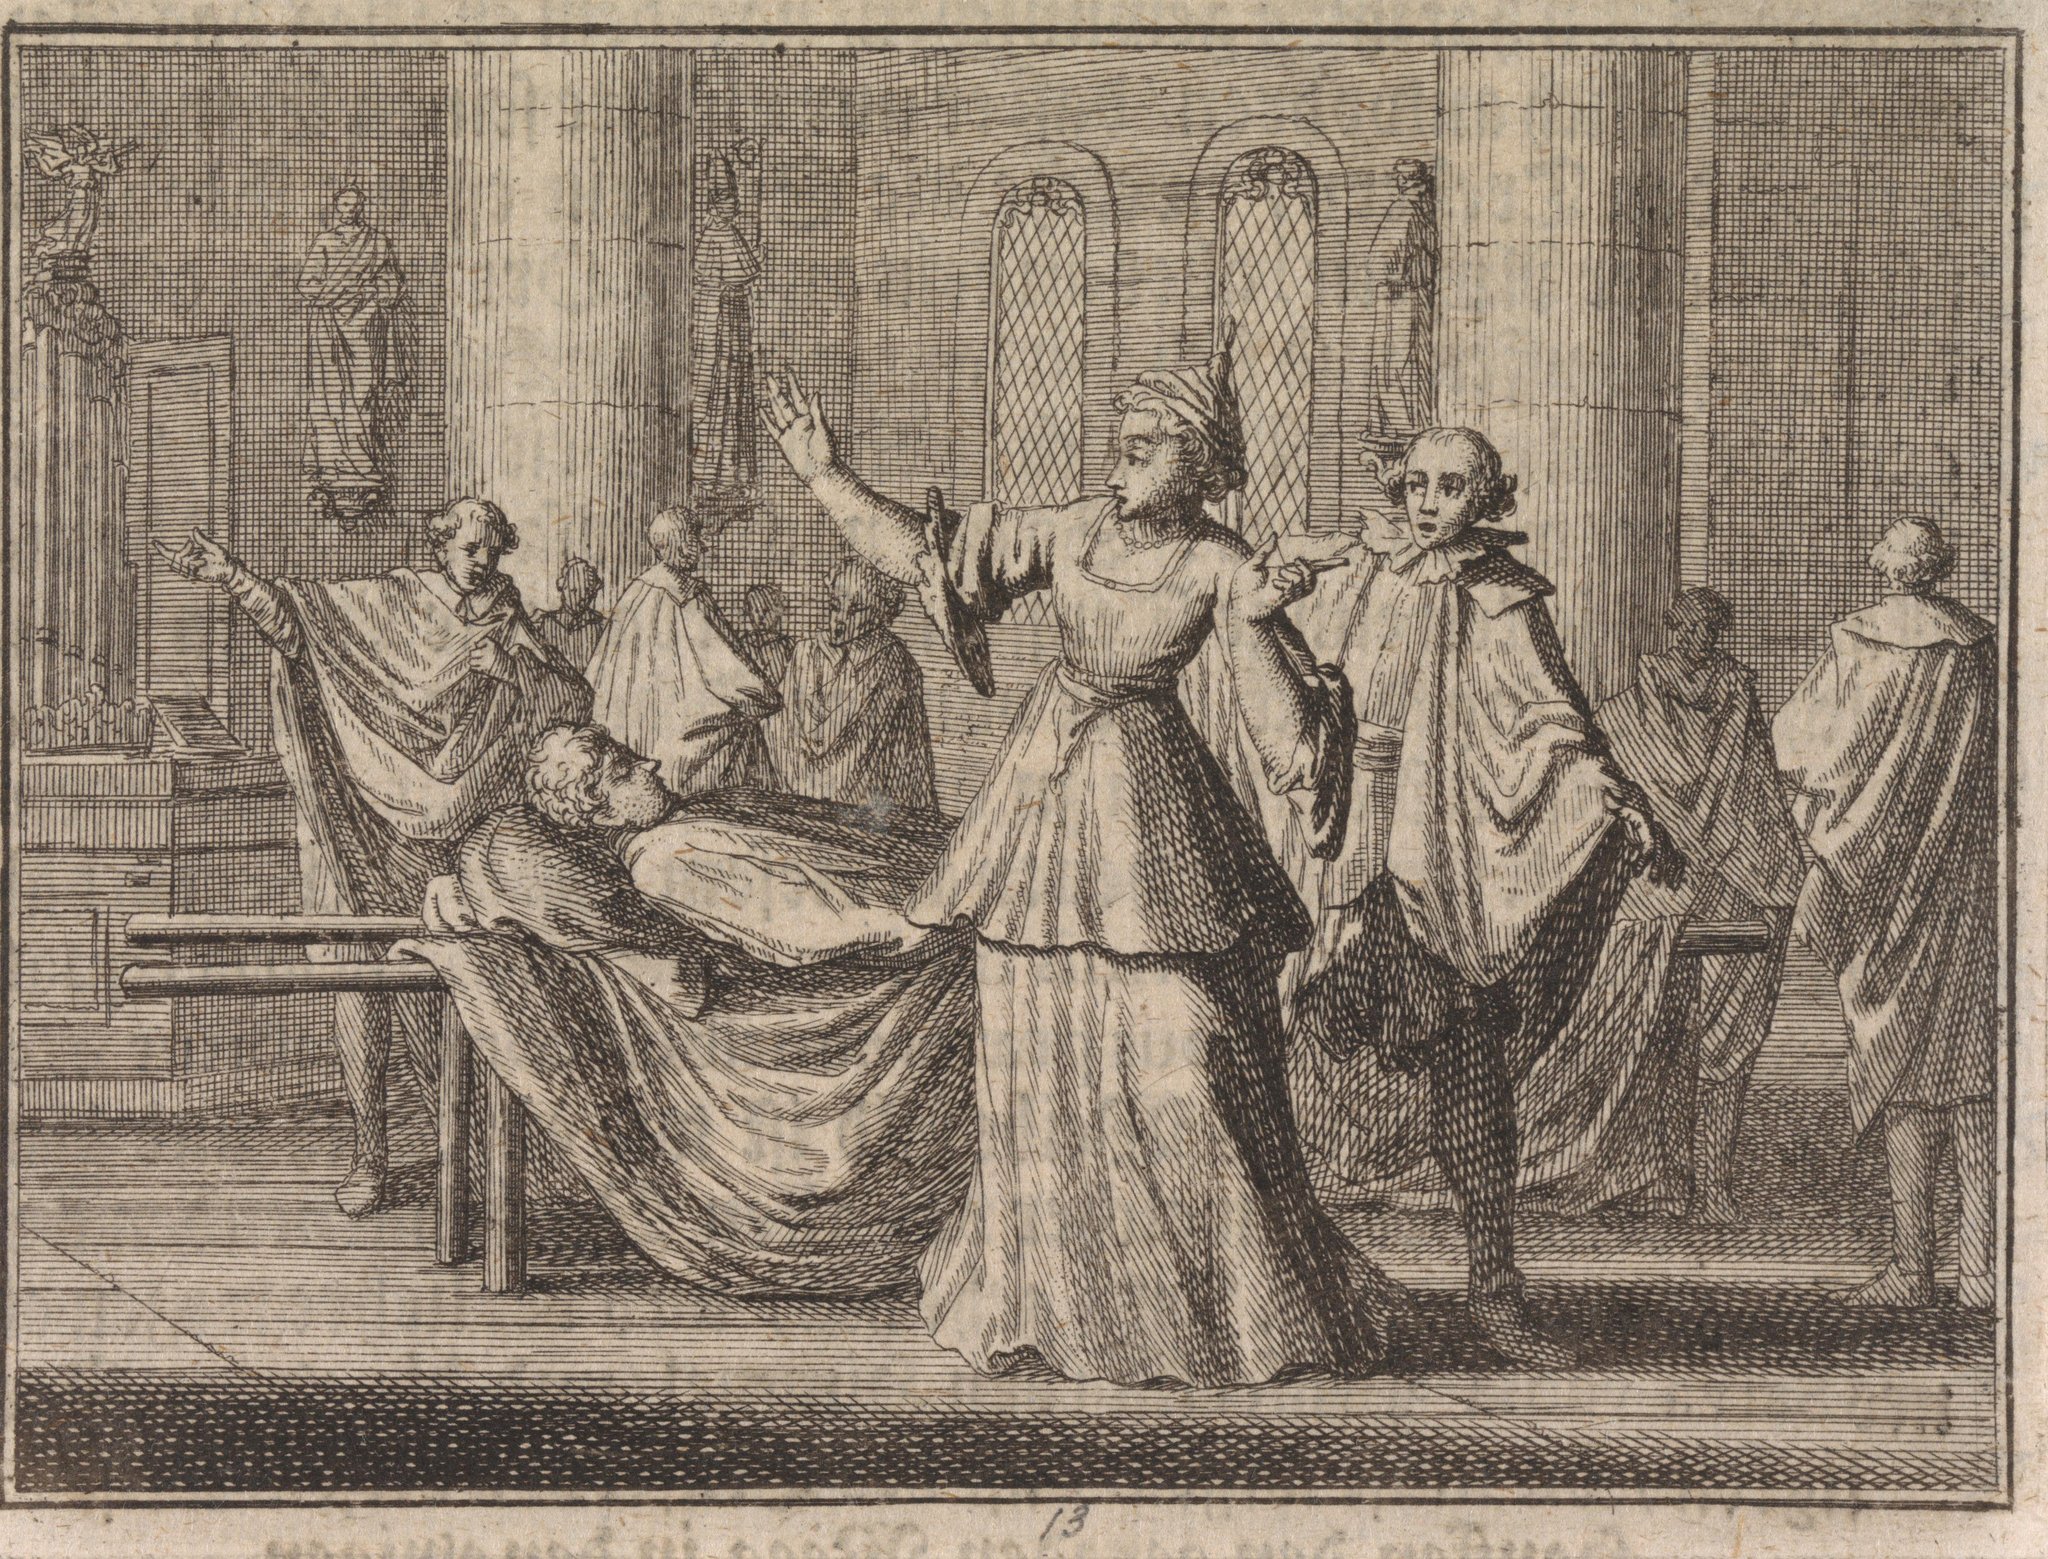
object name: print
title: Vrouw in een kerk bij een lijkbaar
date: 1710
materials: paper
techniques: etching, letterpress printing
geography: nuremberg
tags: interior of church, the corpse placed on a bier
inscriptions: collector's mark: Lugt 2228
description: Illustratie uit: Abraham a Sancta Clara. Heilsames Gemisch Gemasch, das ist: Allerley seltsame und verwunderliche Geschichten (...). Neurenberg: Christoph Weigel, 1710, p. 118.